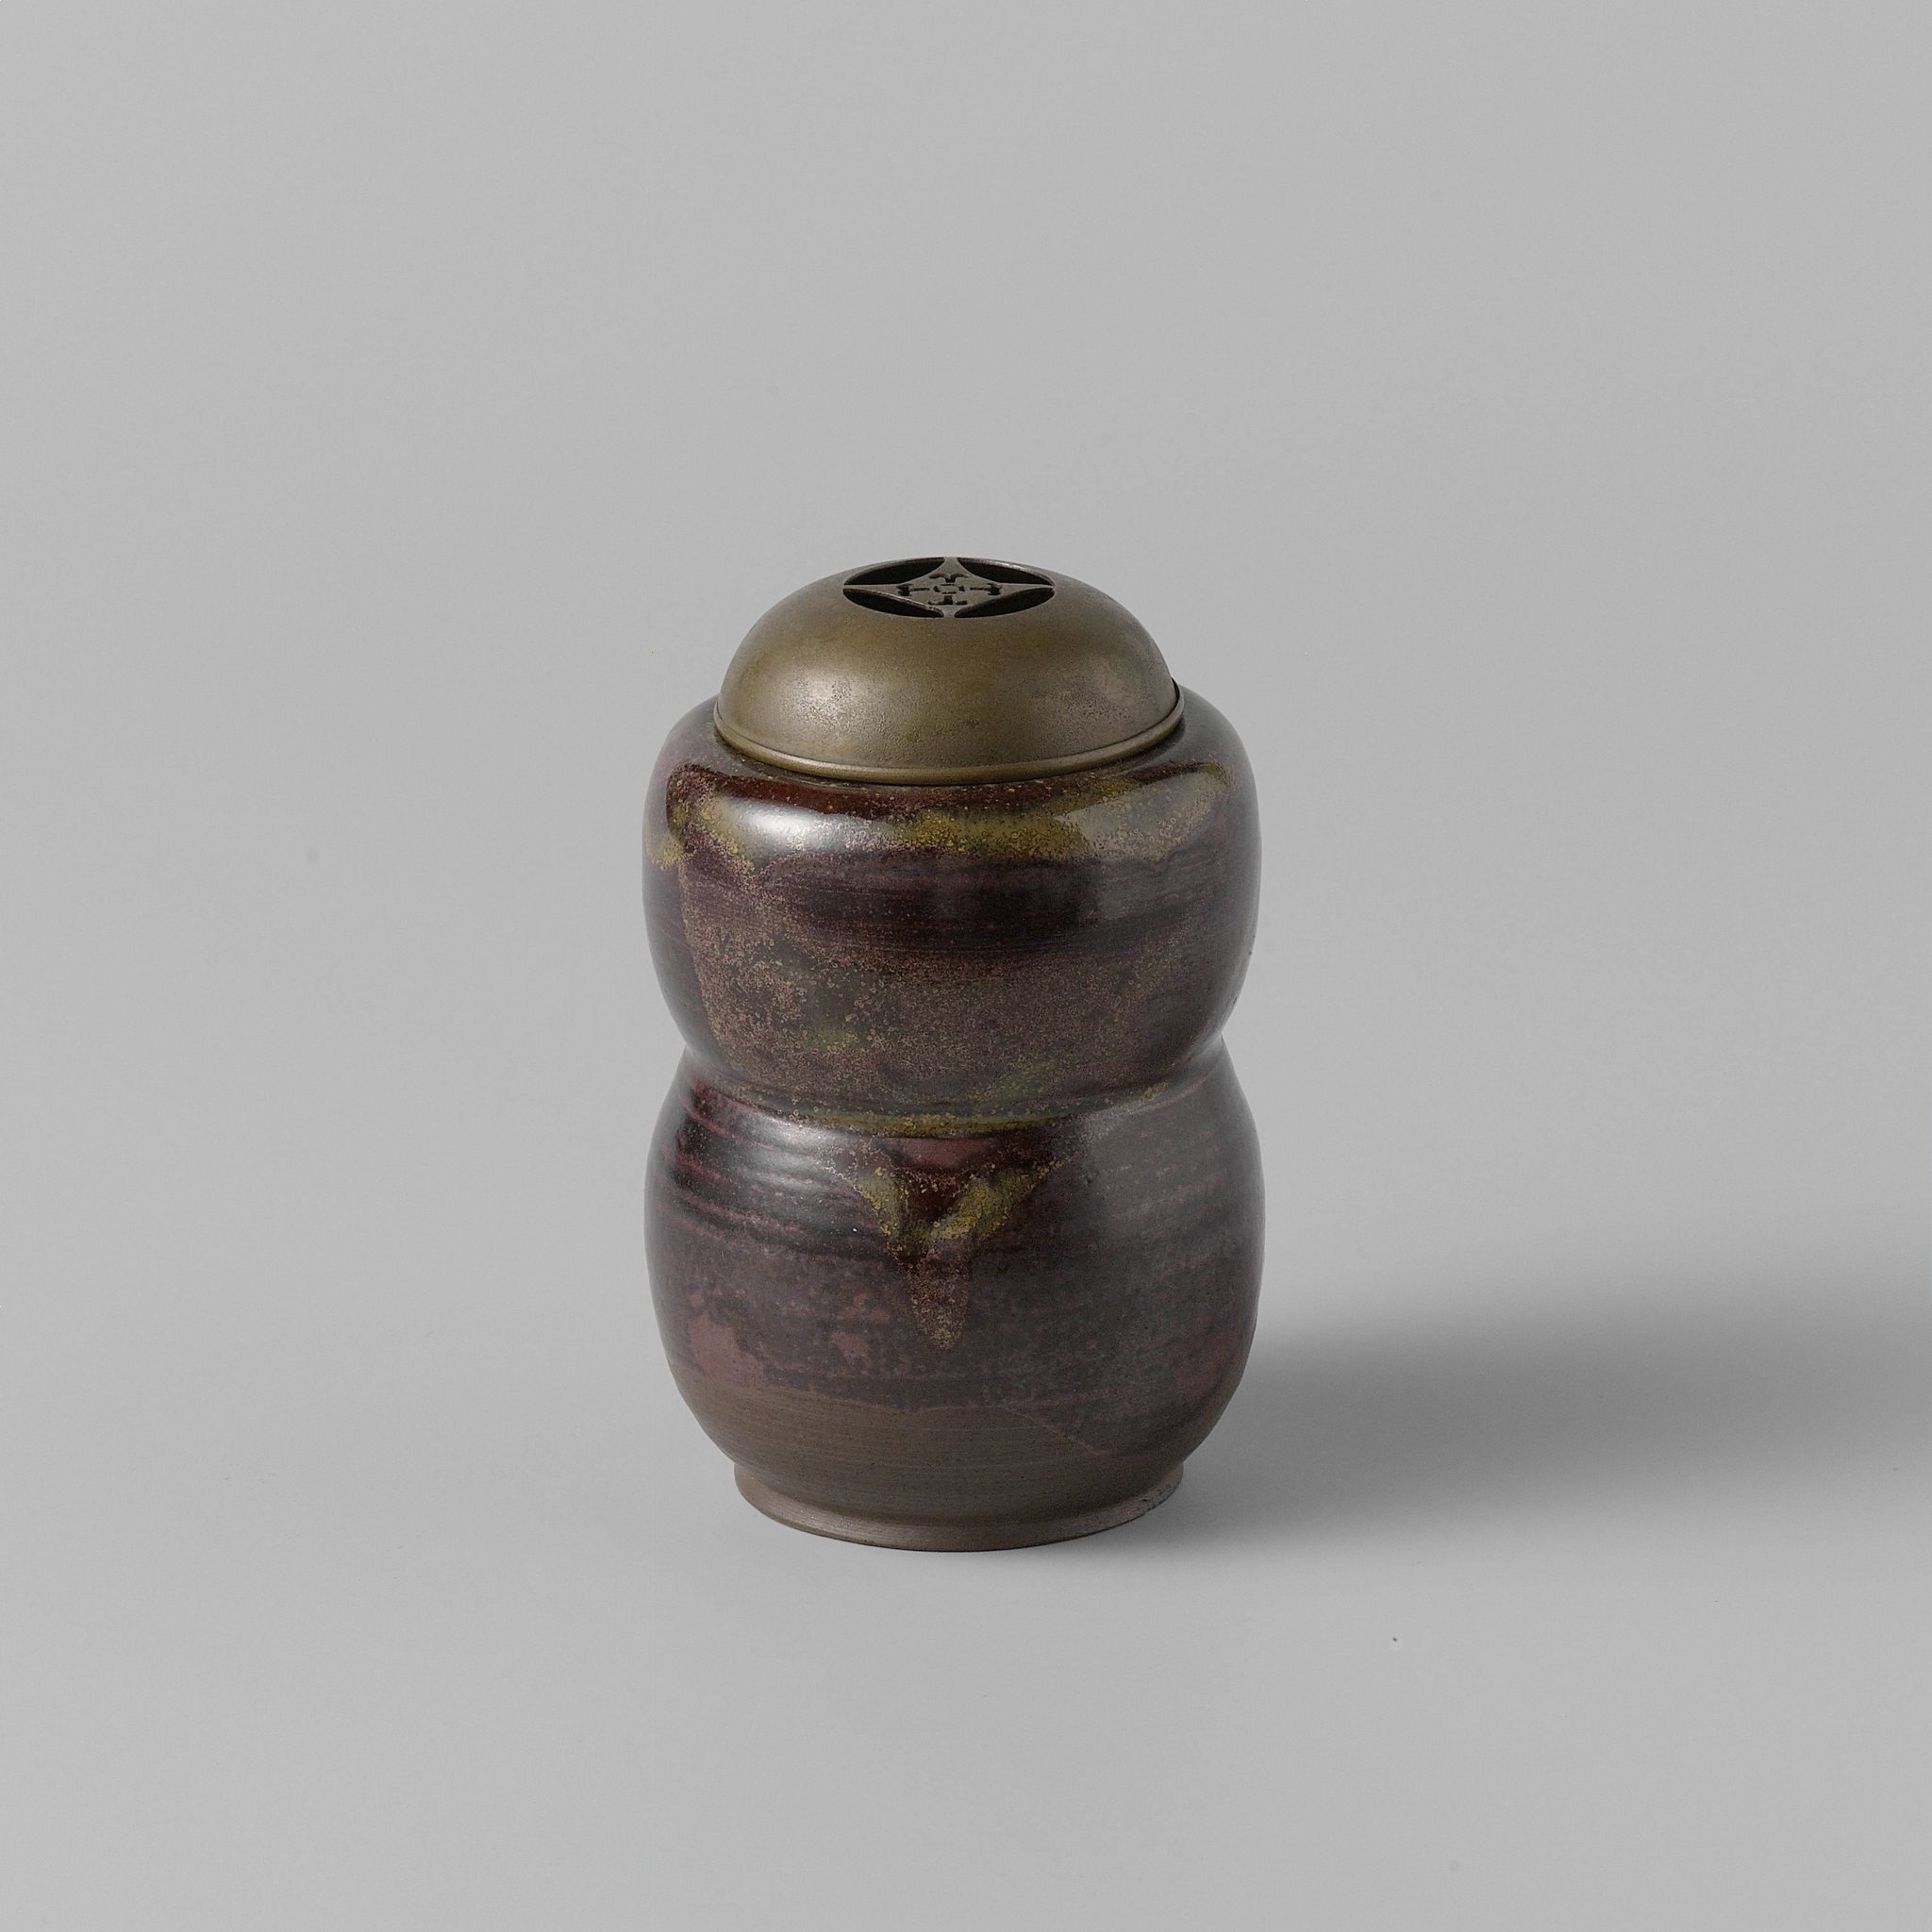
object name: incense burner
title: Insence burner with a metal cover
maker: Anonymous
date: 1600-1868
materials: glaze, metal, stoneware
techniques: firing, turning, vitrification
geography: takatori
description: Wierookbrander (koro) van steengoed met een dubbele kalebasvorm, gedeeltelijk bedekt met een aubergine en okerkleurig glazuur. De deksel is aan de bovenzijde opengewerkt. Takatori of Shigaraki.